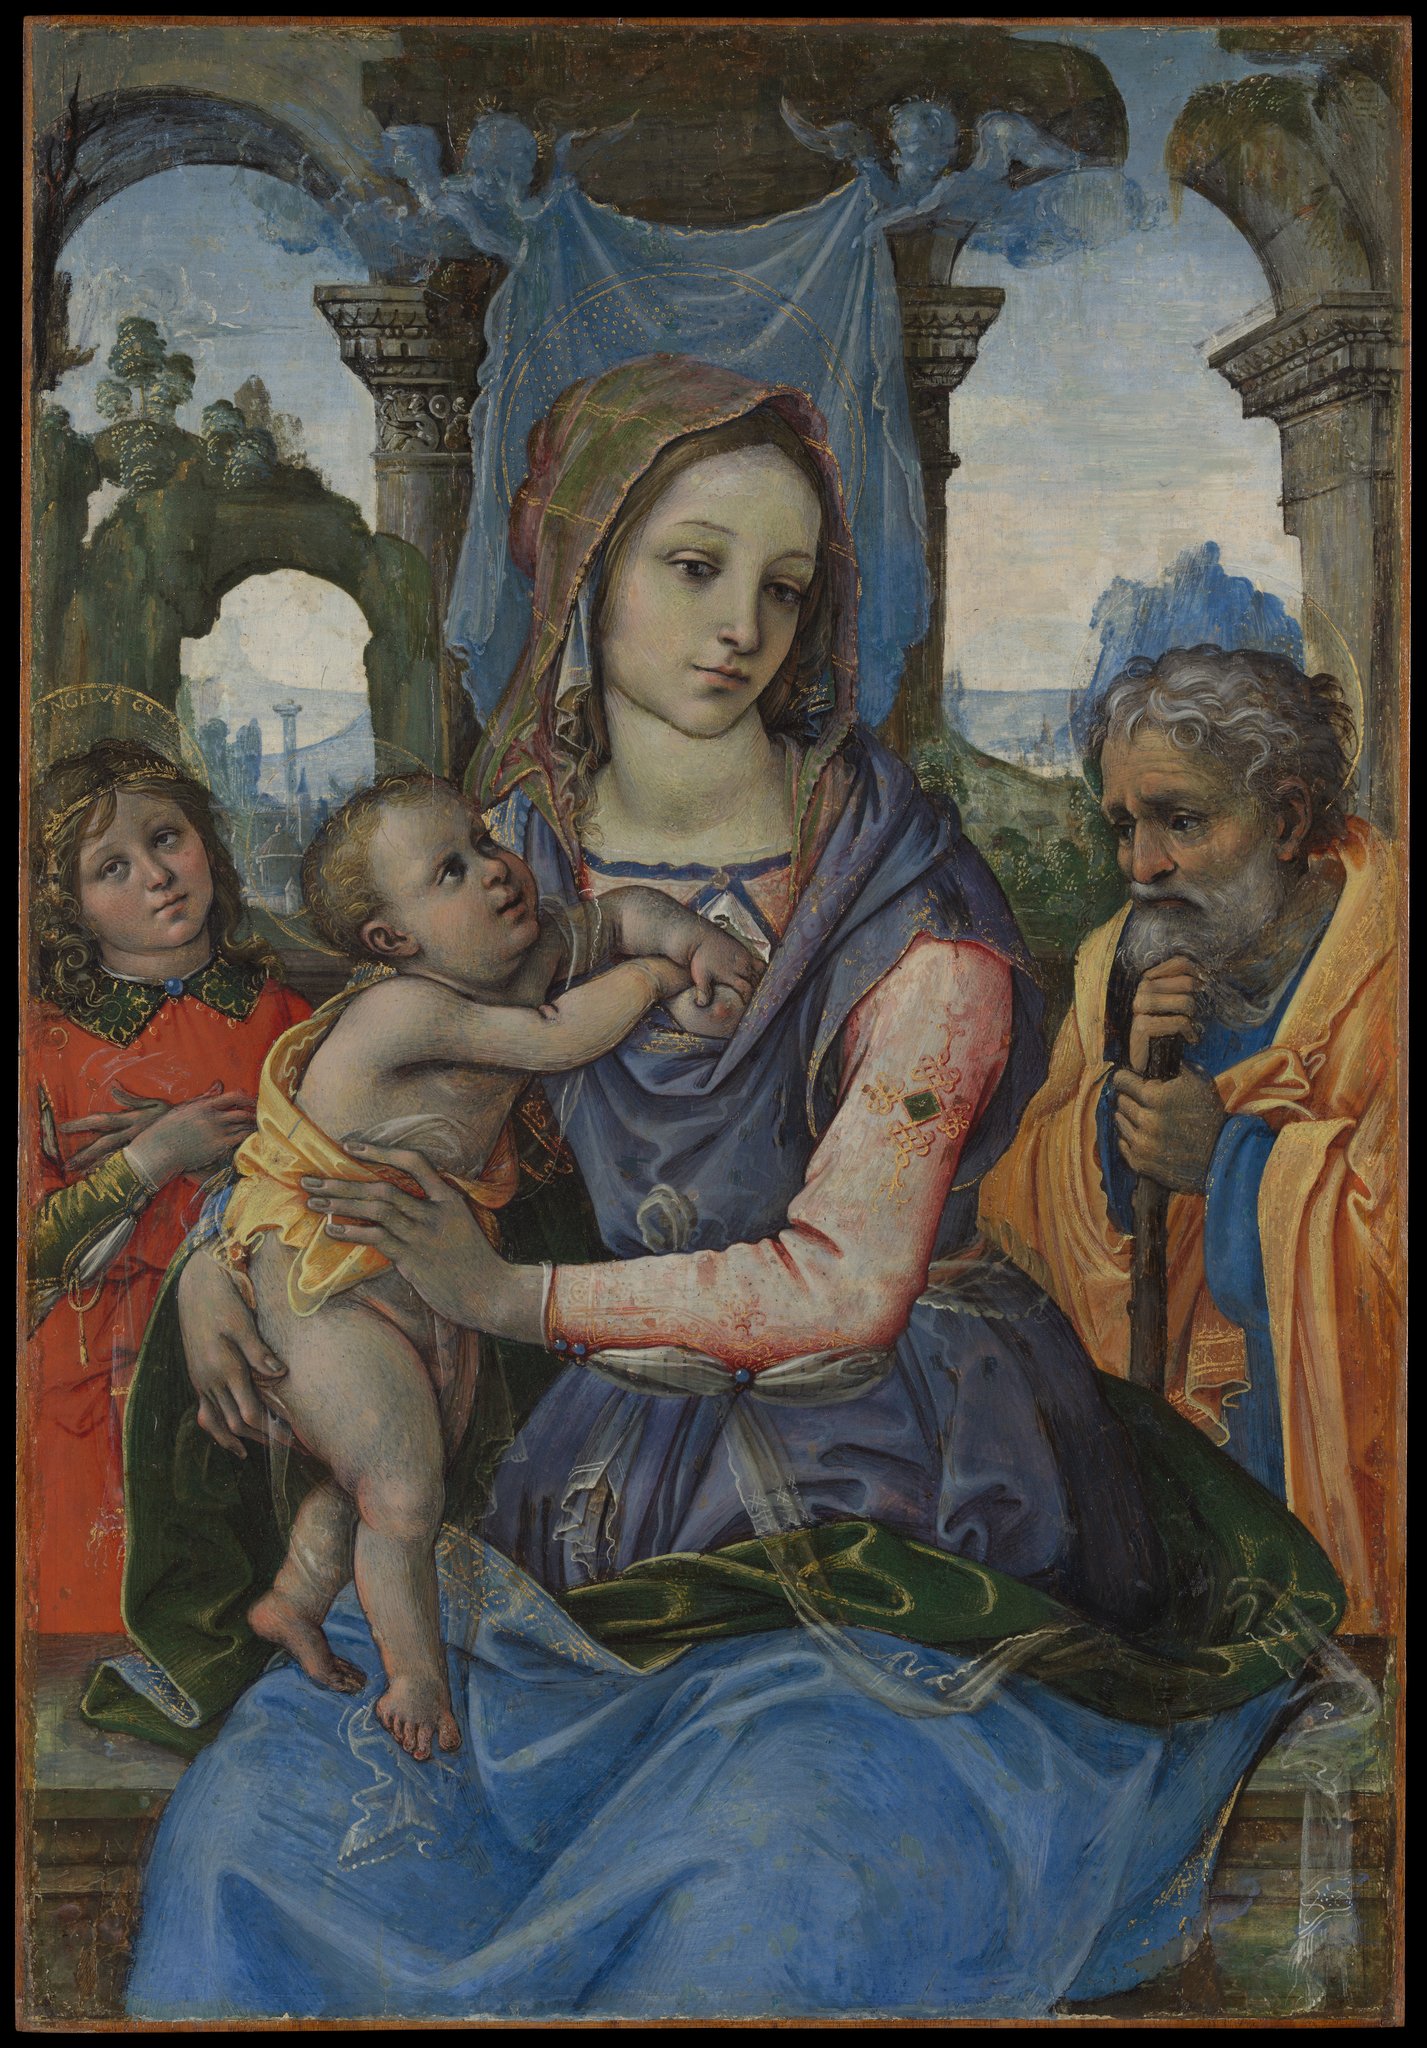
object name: painting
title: Holy Family with an Angel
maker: raffaellino del garbo (also known as raffaelle de' capponi and raffaelle de' carli)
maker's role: artist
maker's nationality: italian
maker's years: 1465-1527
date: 1490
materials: canvas, paint, wood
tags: angels,madonna and child,saint joseph